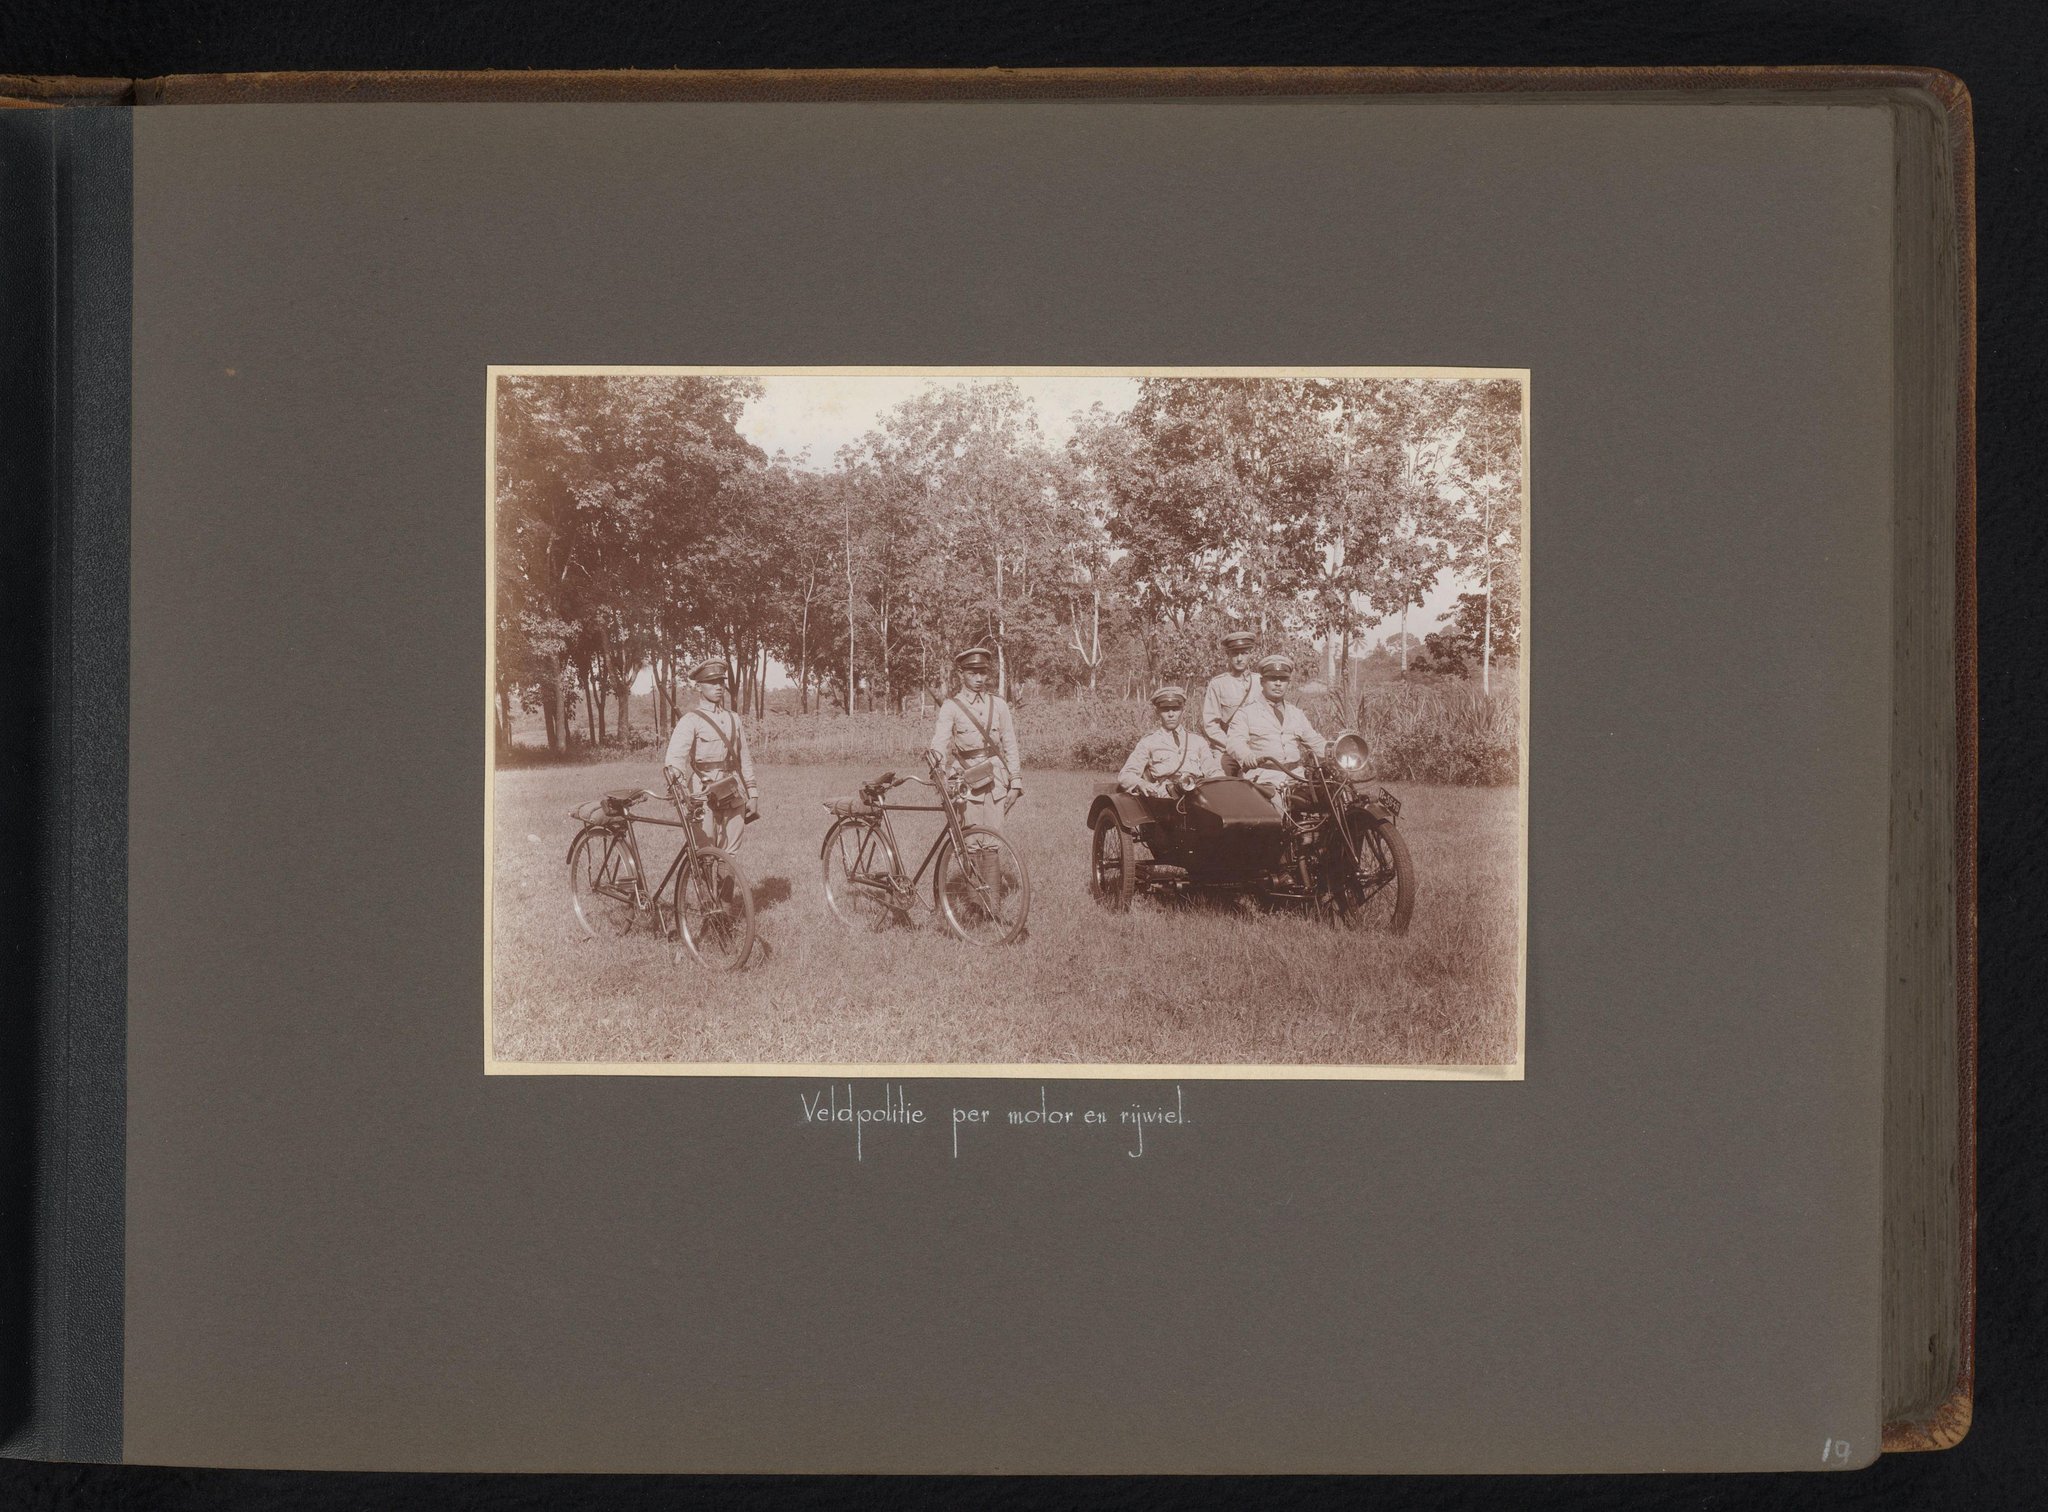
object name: photograph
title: Veldpolitie per motor en rijwiel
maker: Anonymous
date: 1925-1931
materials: cardboard, photographic support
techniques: collodion silver print, gelatin silver print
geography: batavia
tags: dutch east indies, the, batavia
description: Albumblad met één foto: twee agenten met fietsen en drie agenten op een motor met zijspan van de veldpolitie te Batavia. Onderdeel van het fotoalbum aangeboden aan S. Koster door de Vereeniging van Hoogere Politie Ambtenaren in Nederlandsch-Indië in 1931.